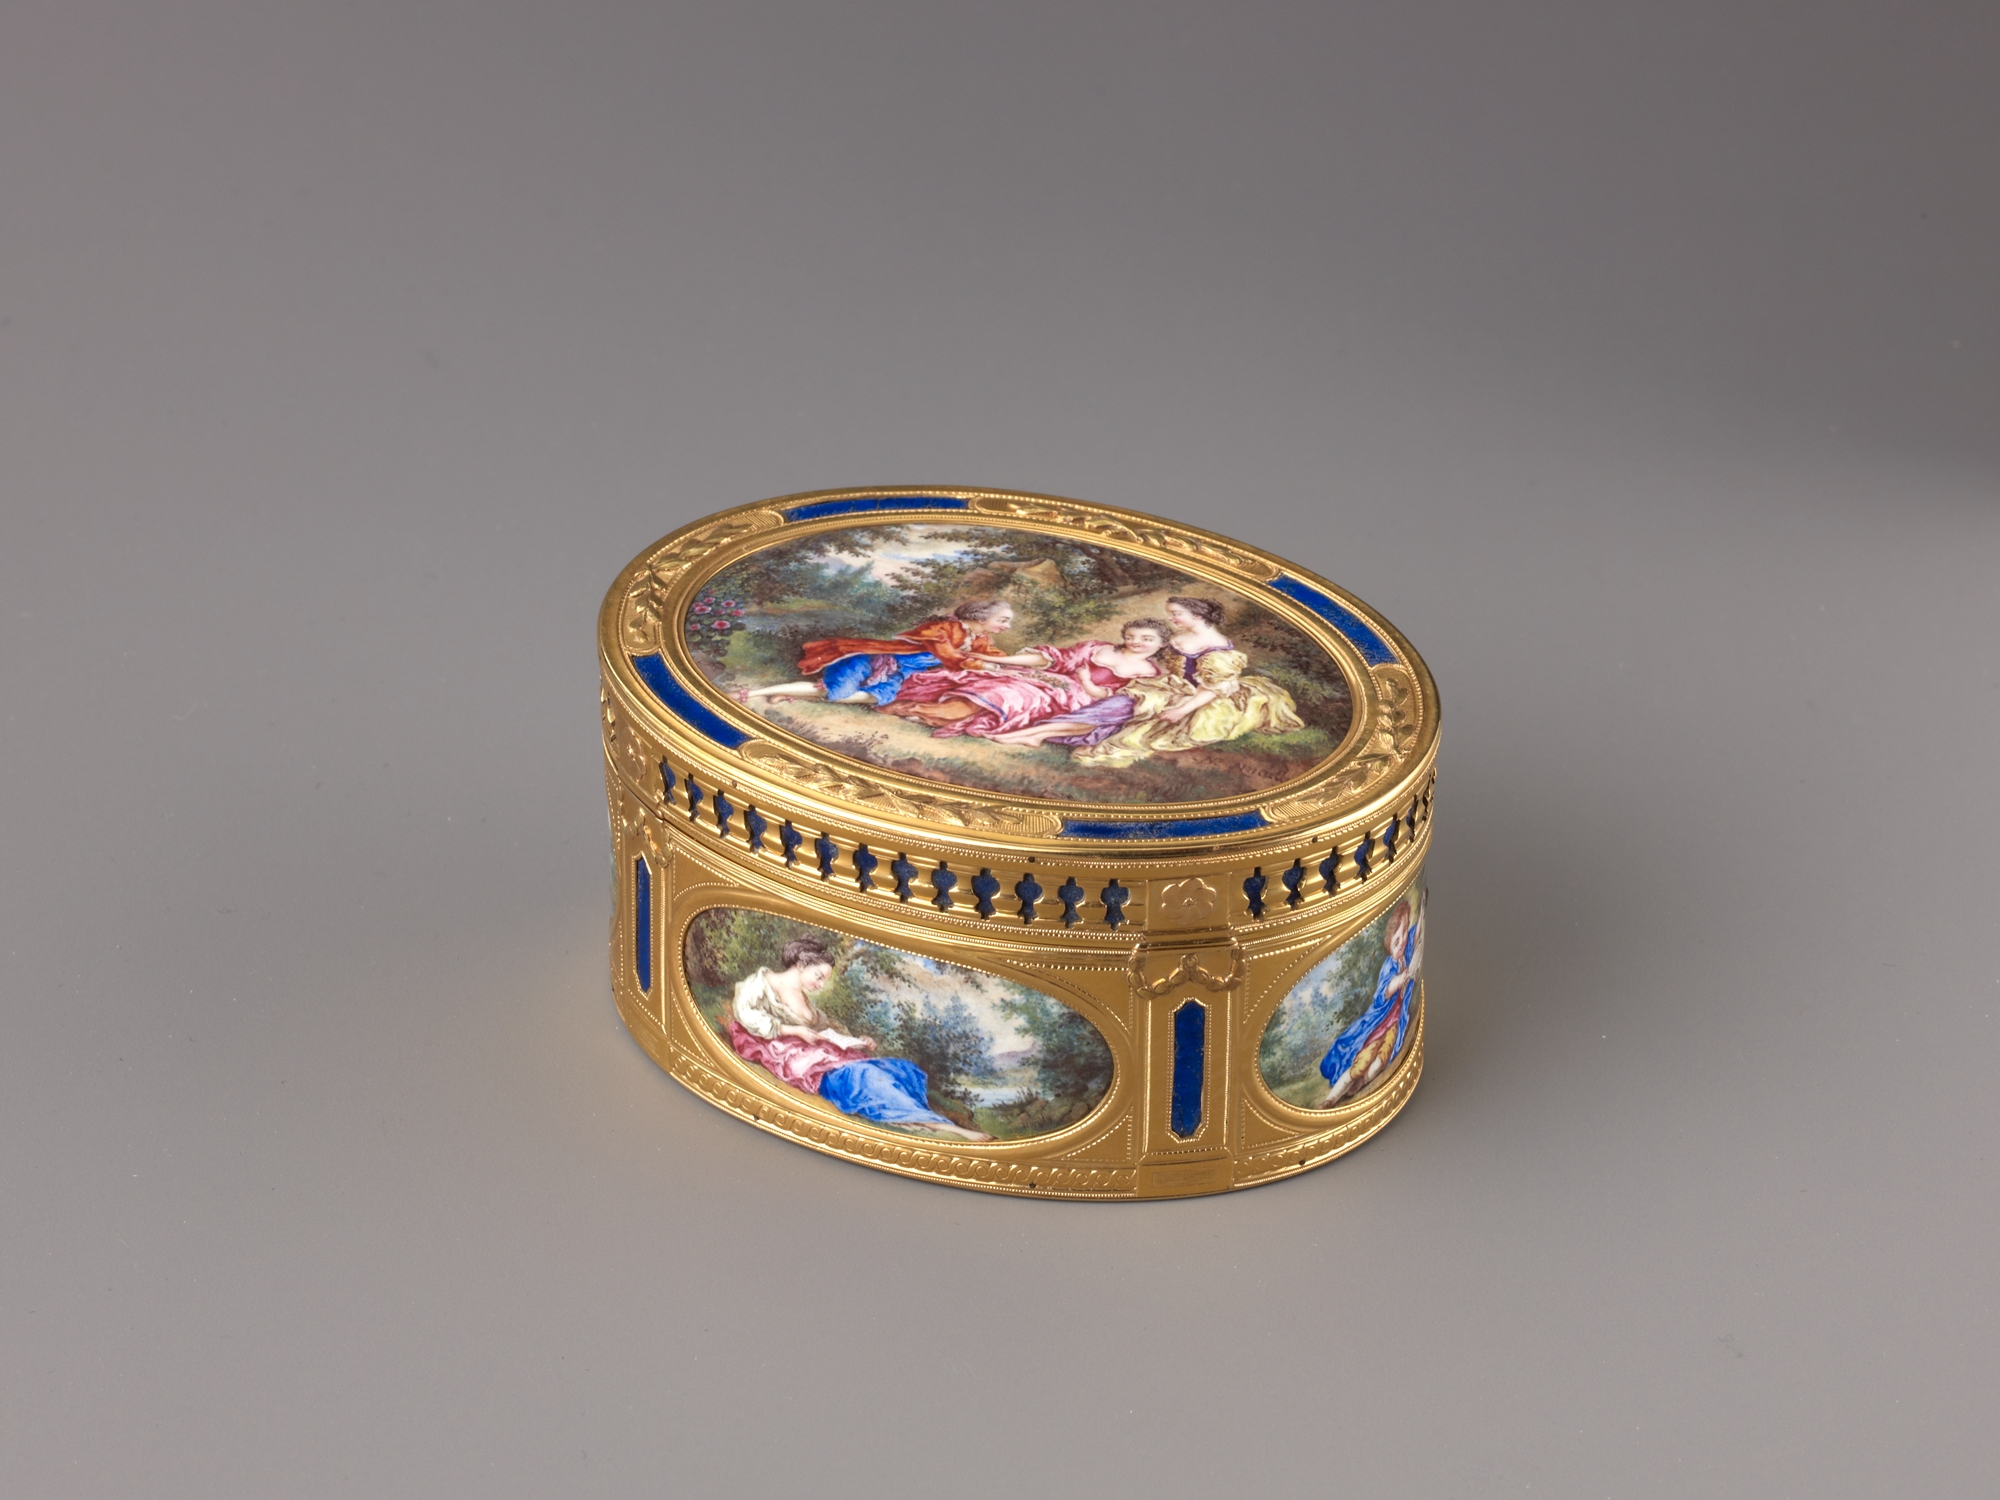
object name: snuffbox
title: Snuffbox with Pastoral Scenes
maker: jean marie tiron (called tiron de nanteuil)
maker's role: artist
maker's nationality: french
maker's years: 1748-1793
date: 1764-1765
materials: enamel, gold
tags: men,women